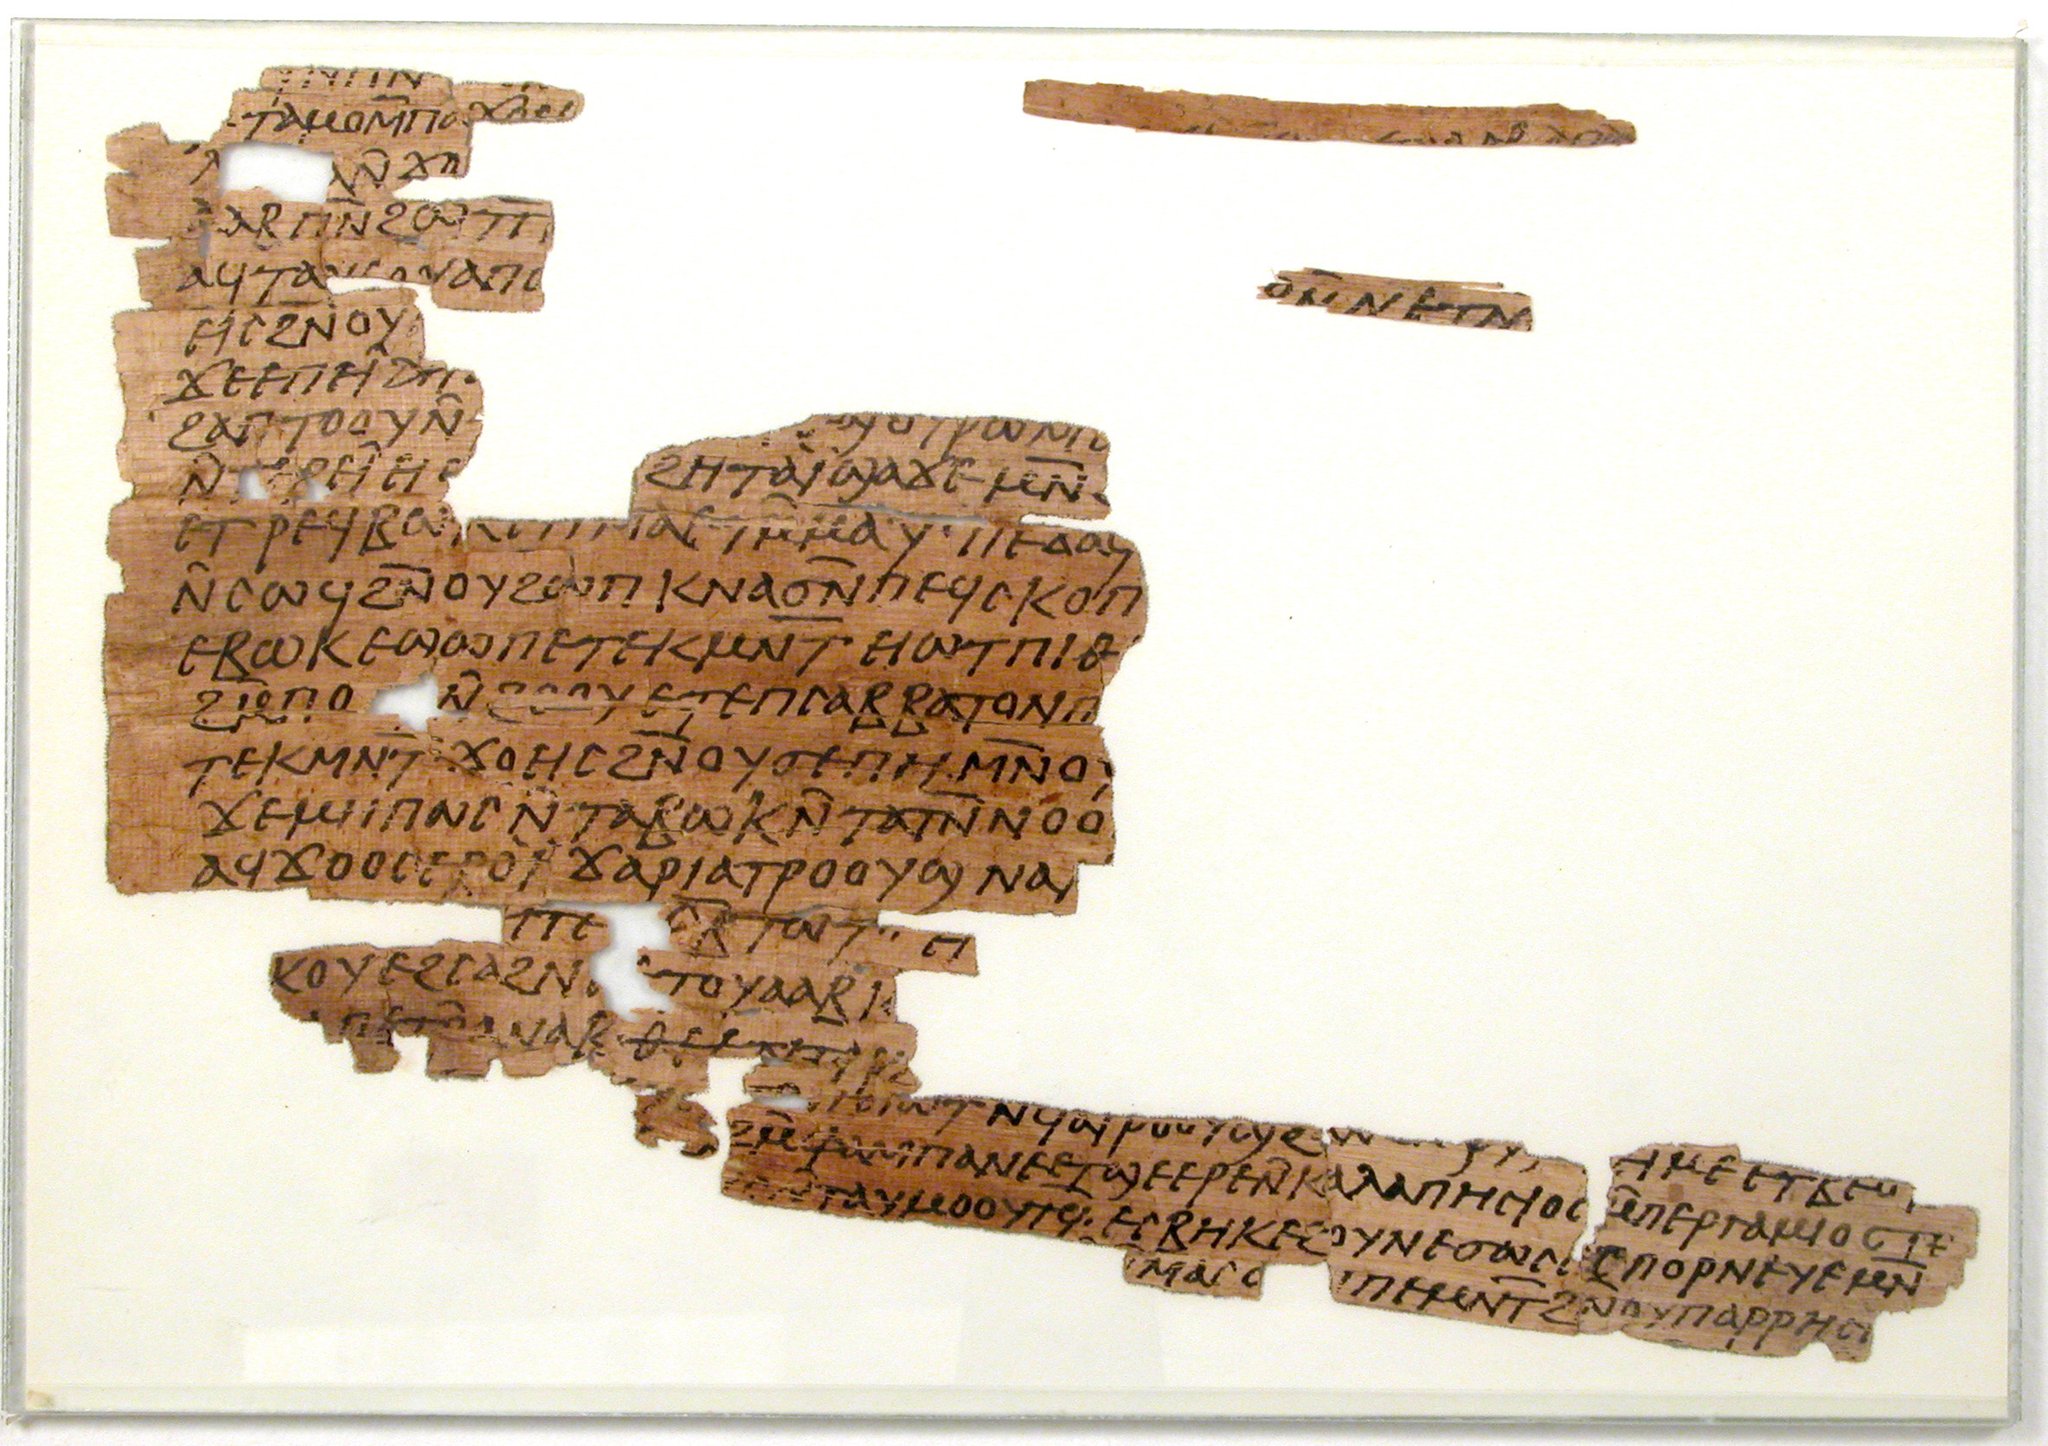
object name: fragment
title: Papyrus Fragment of a Letter and Grain Account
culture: coptic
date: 580-640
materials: ink, papyrus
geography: egypt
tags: coptic,documents